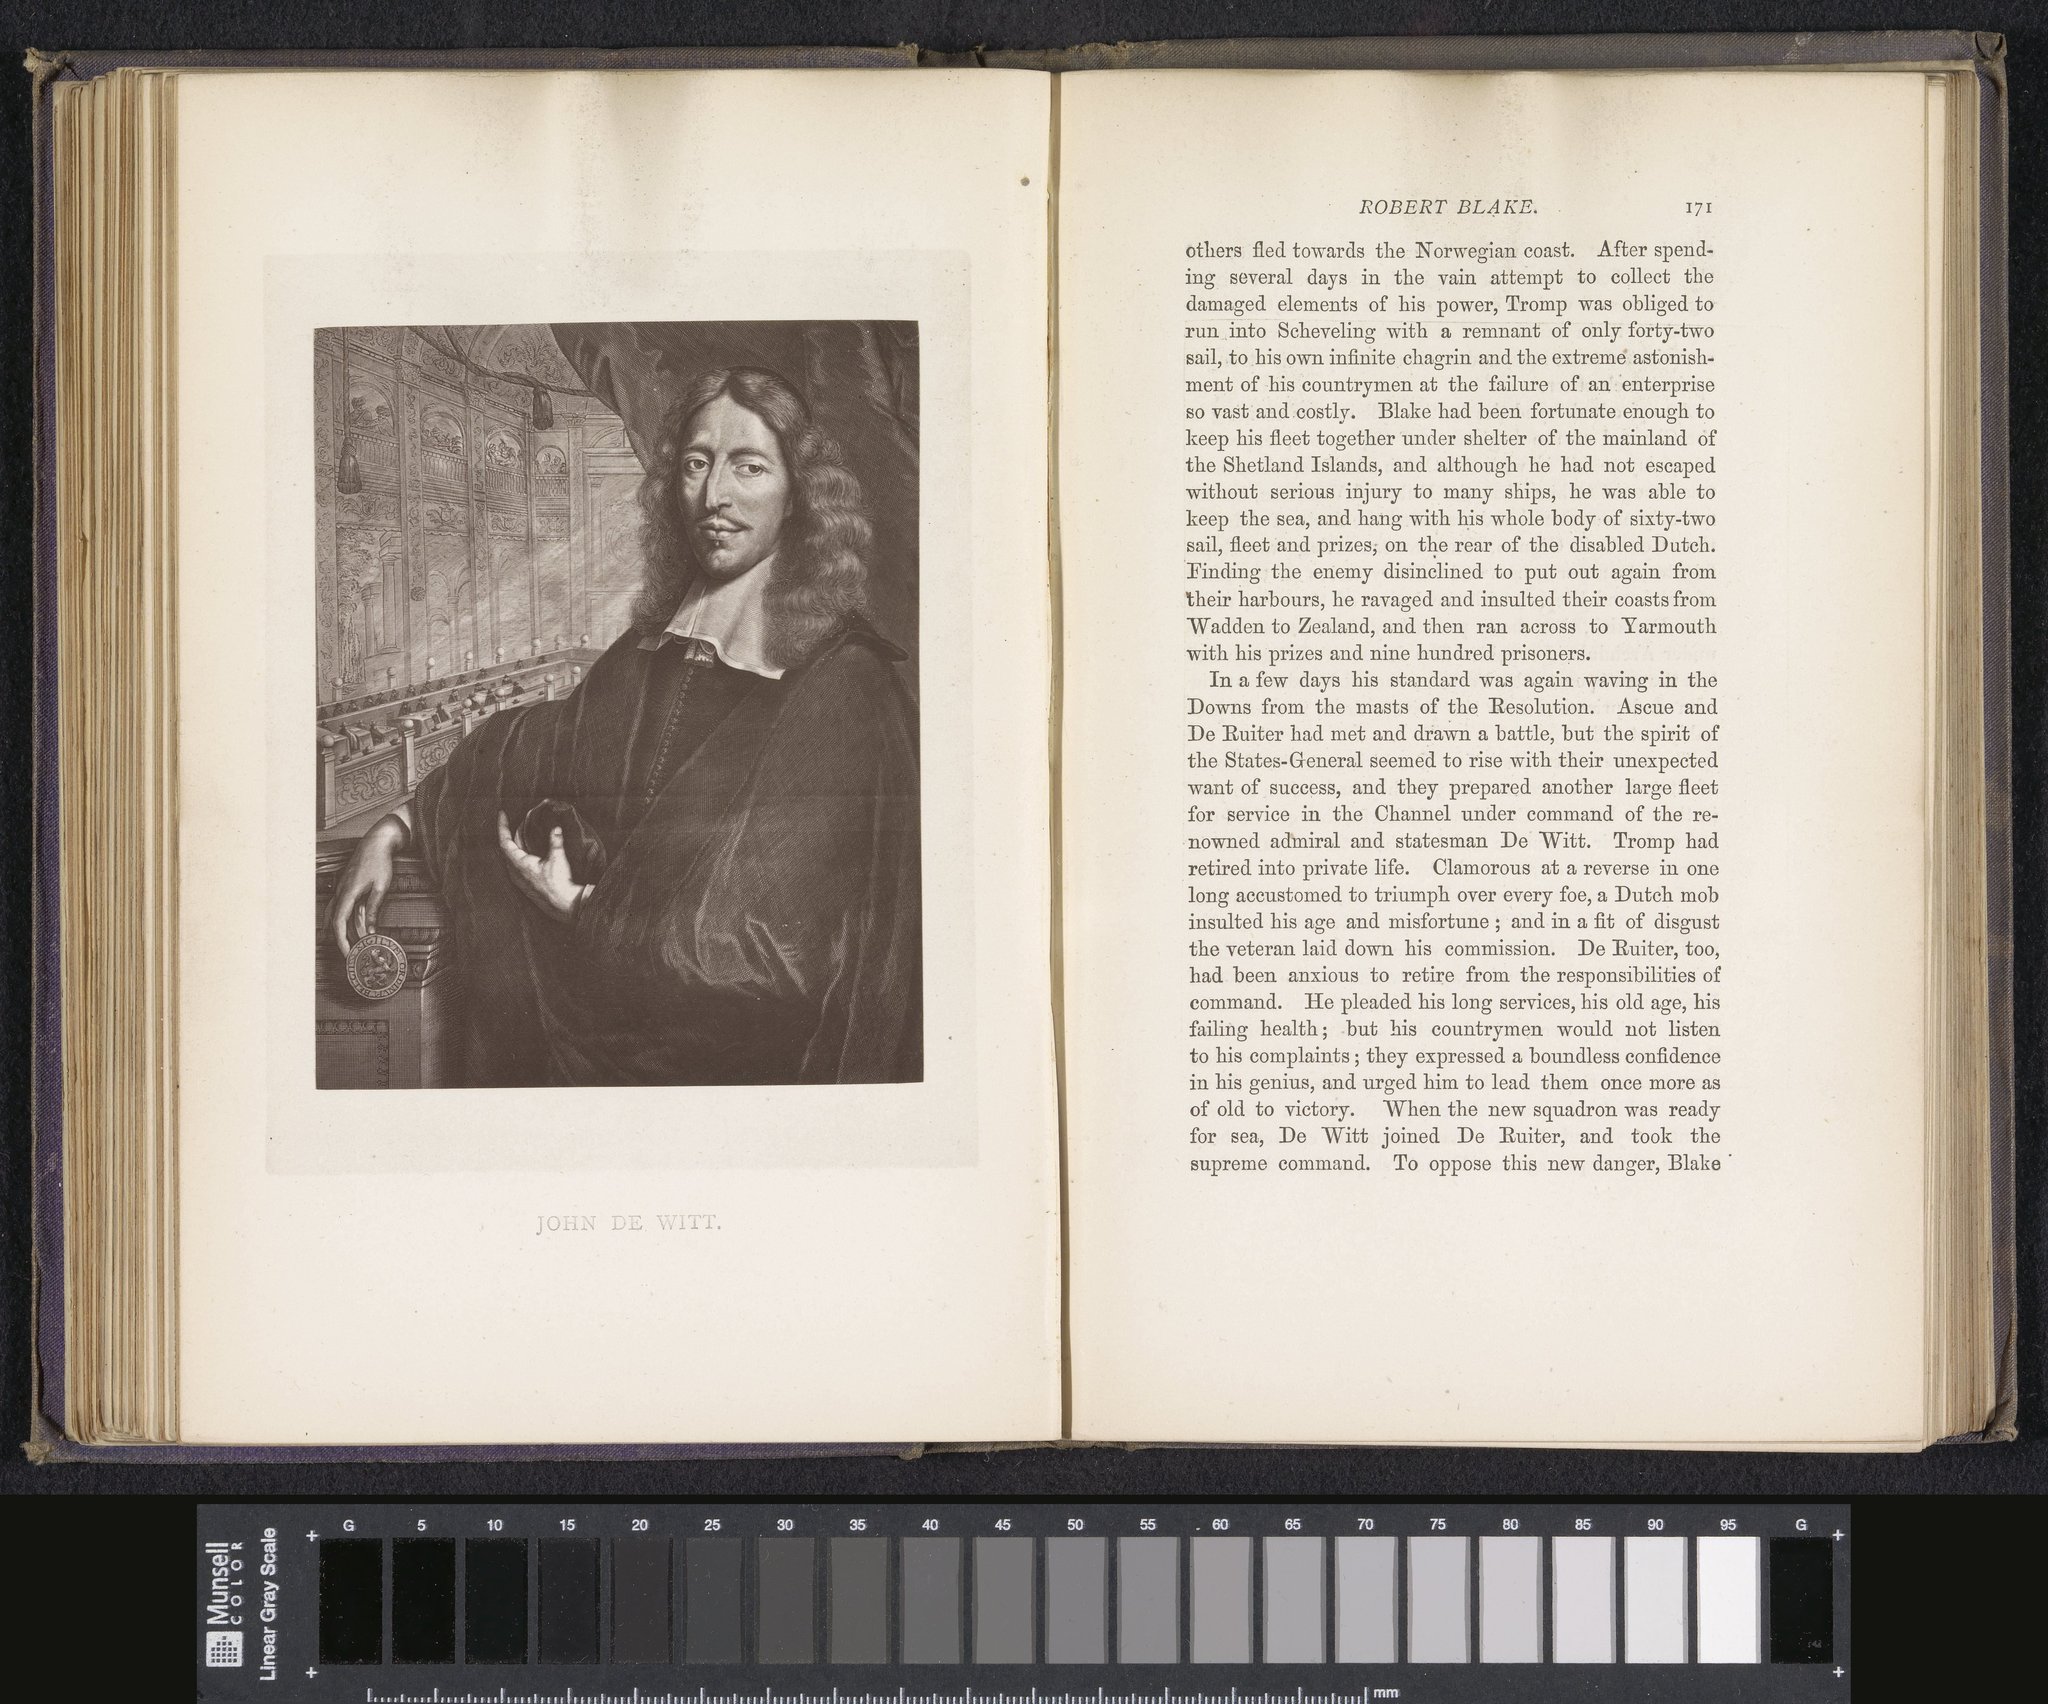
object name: reproduction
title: John de Witt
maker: Anonymous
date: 1875-1885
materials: paper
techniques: woodburytype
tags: the hague, politician, johan de witt, politician, e.g. party leader